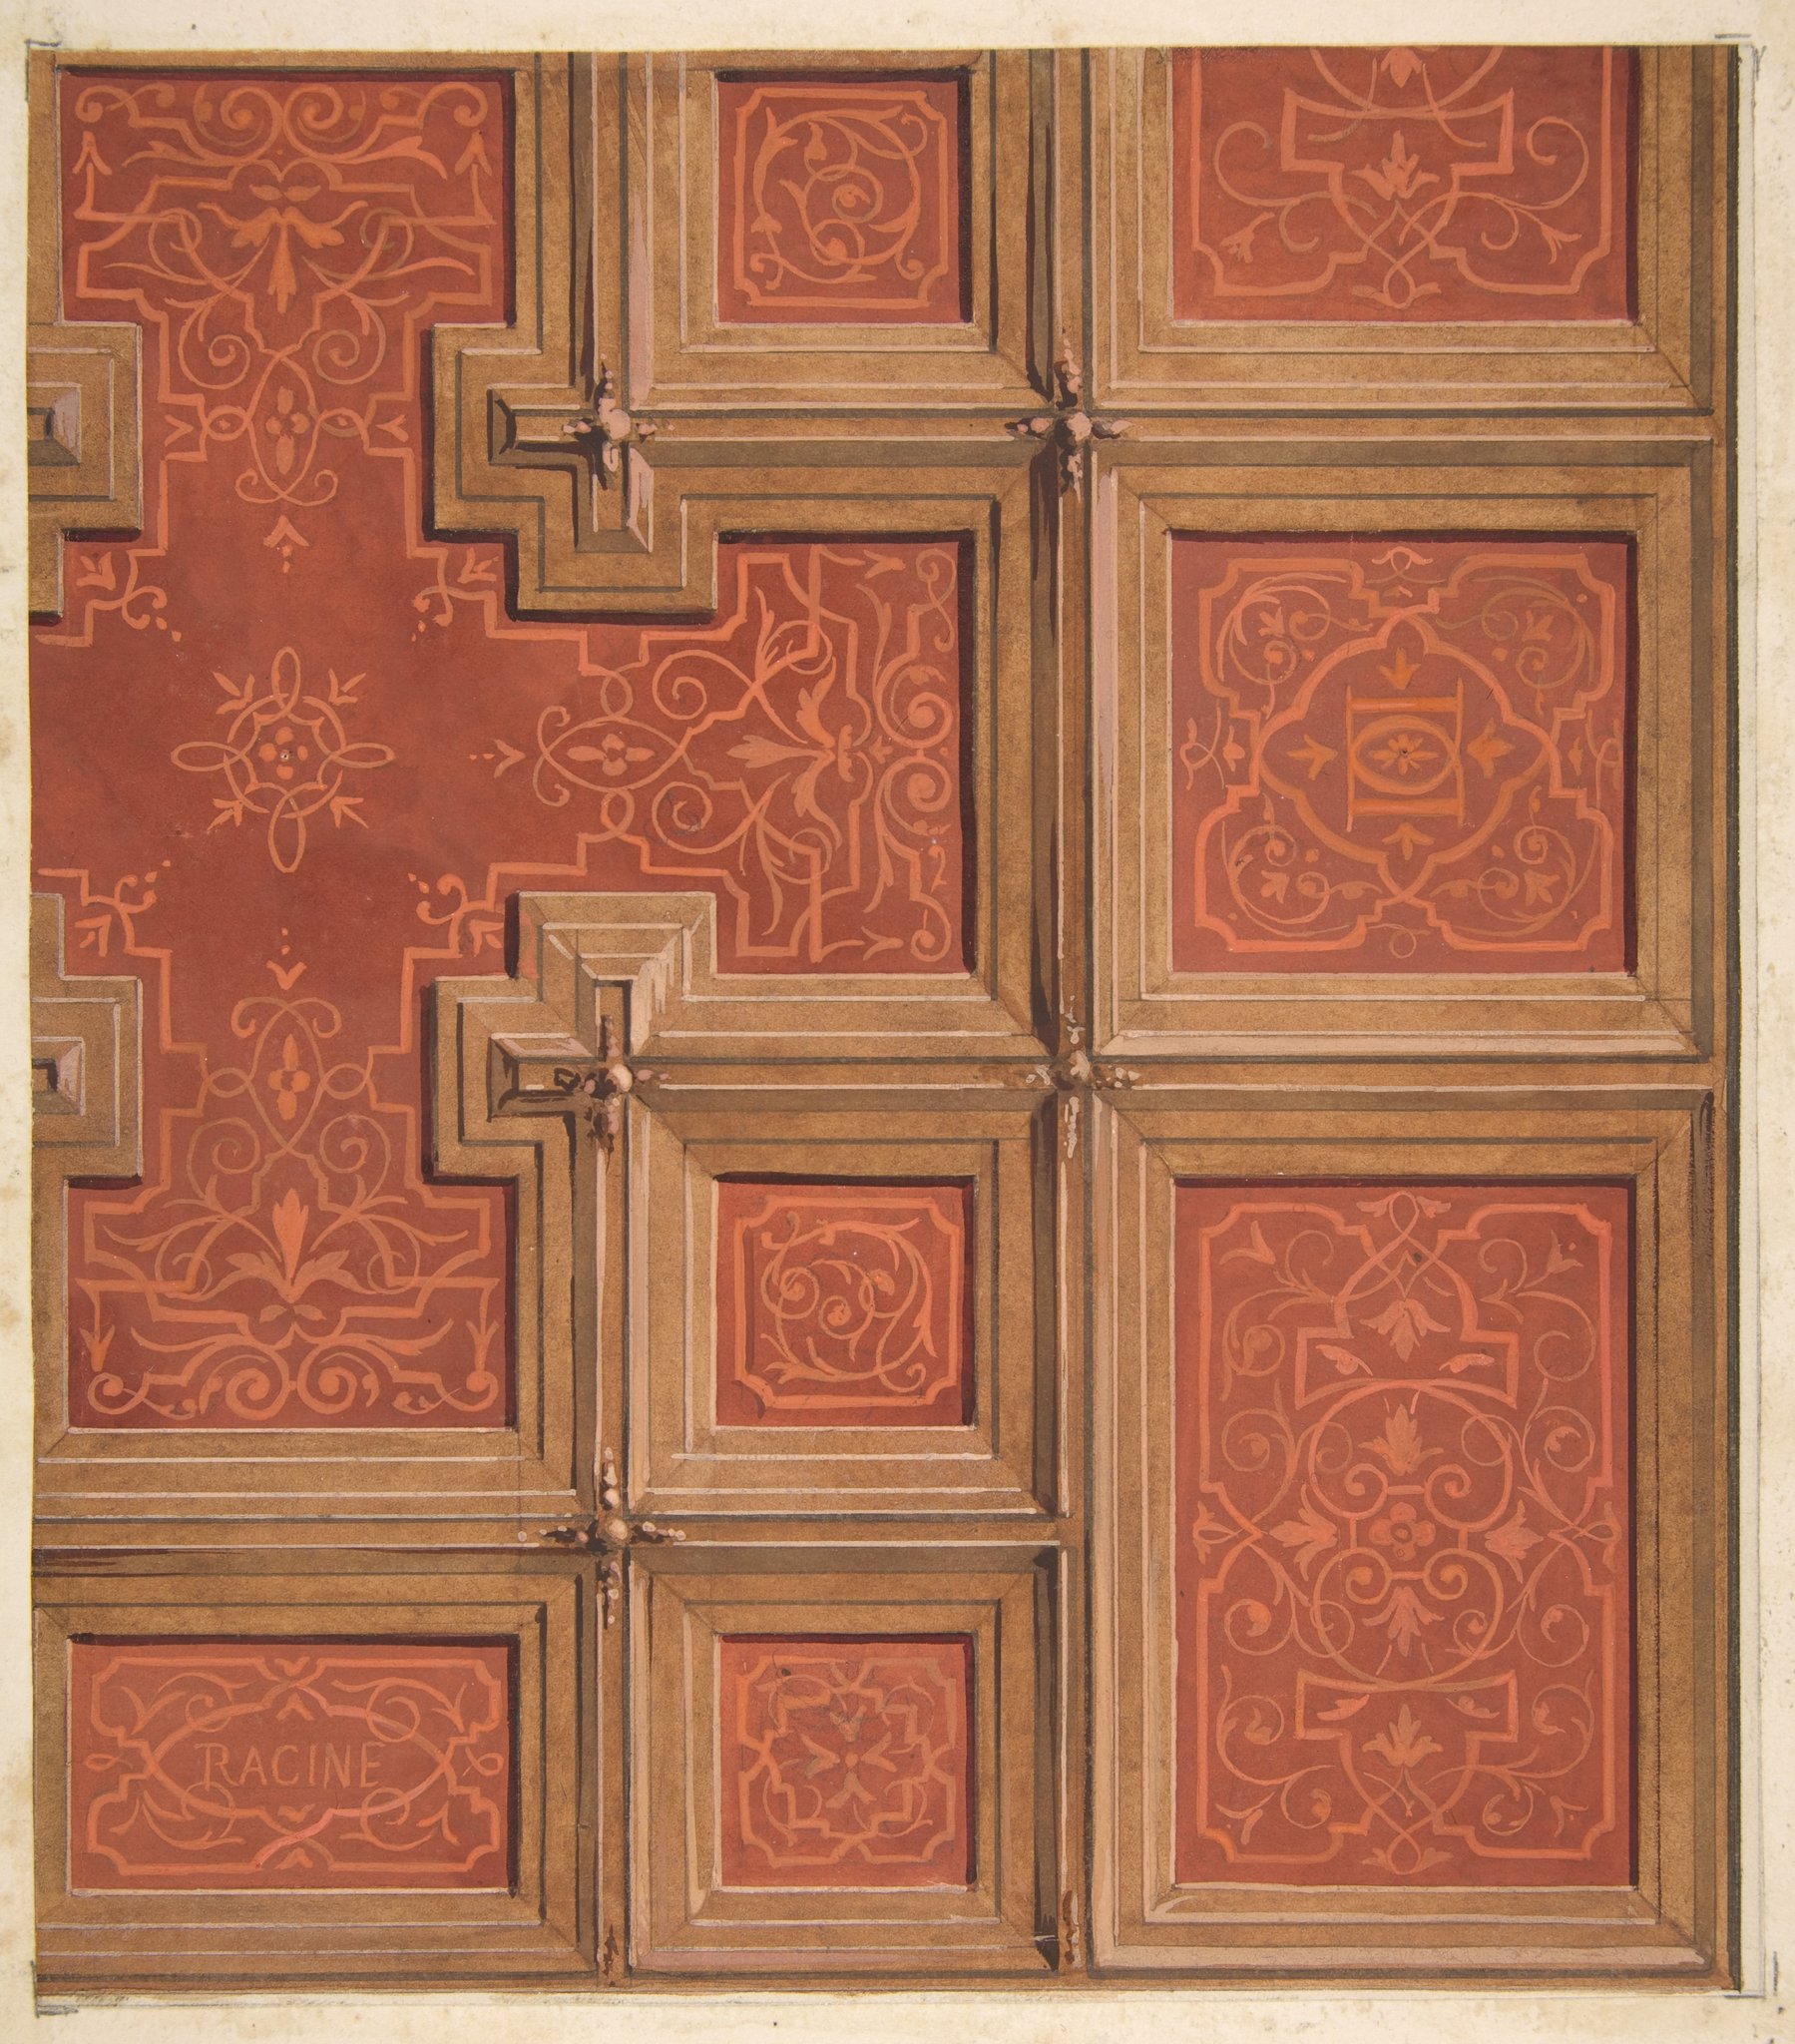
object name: drawing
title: Design for the decoration of a coffered ceiling ornamented with the name "Racine" and entwined letters: DD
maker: jules-edmond-charles lachaise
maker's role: artist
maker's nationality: french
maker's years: 1897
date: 1851-1900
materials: gouache, graphite, watercolor, paper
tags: ceilings